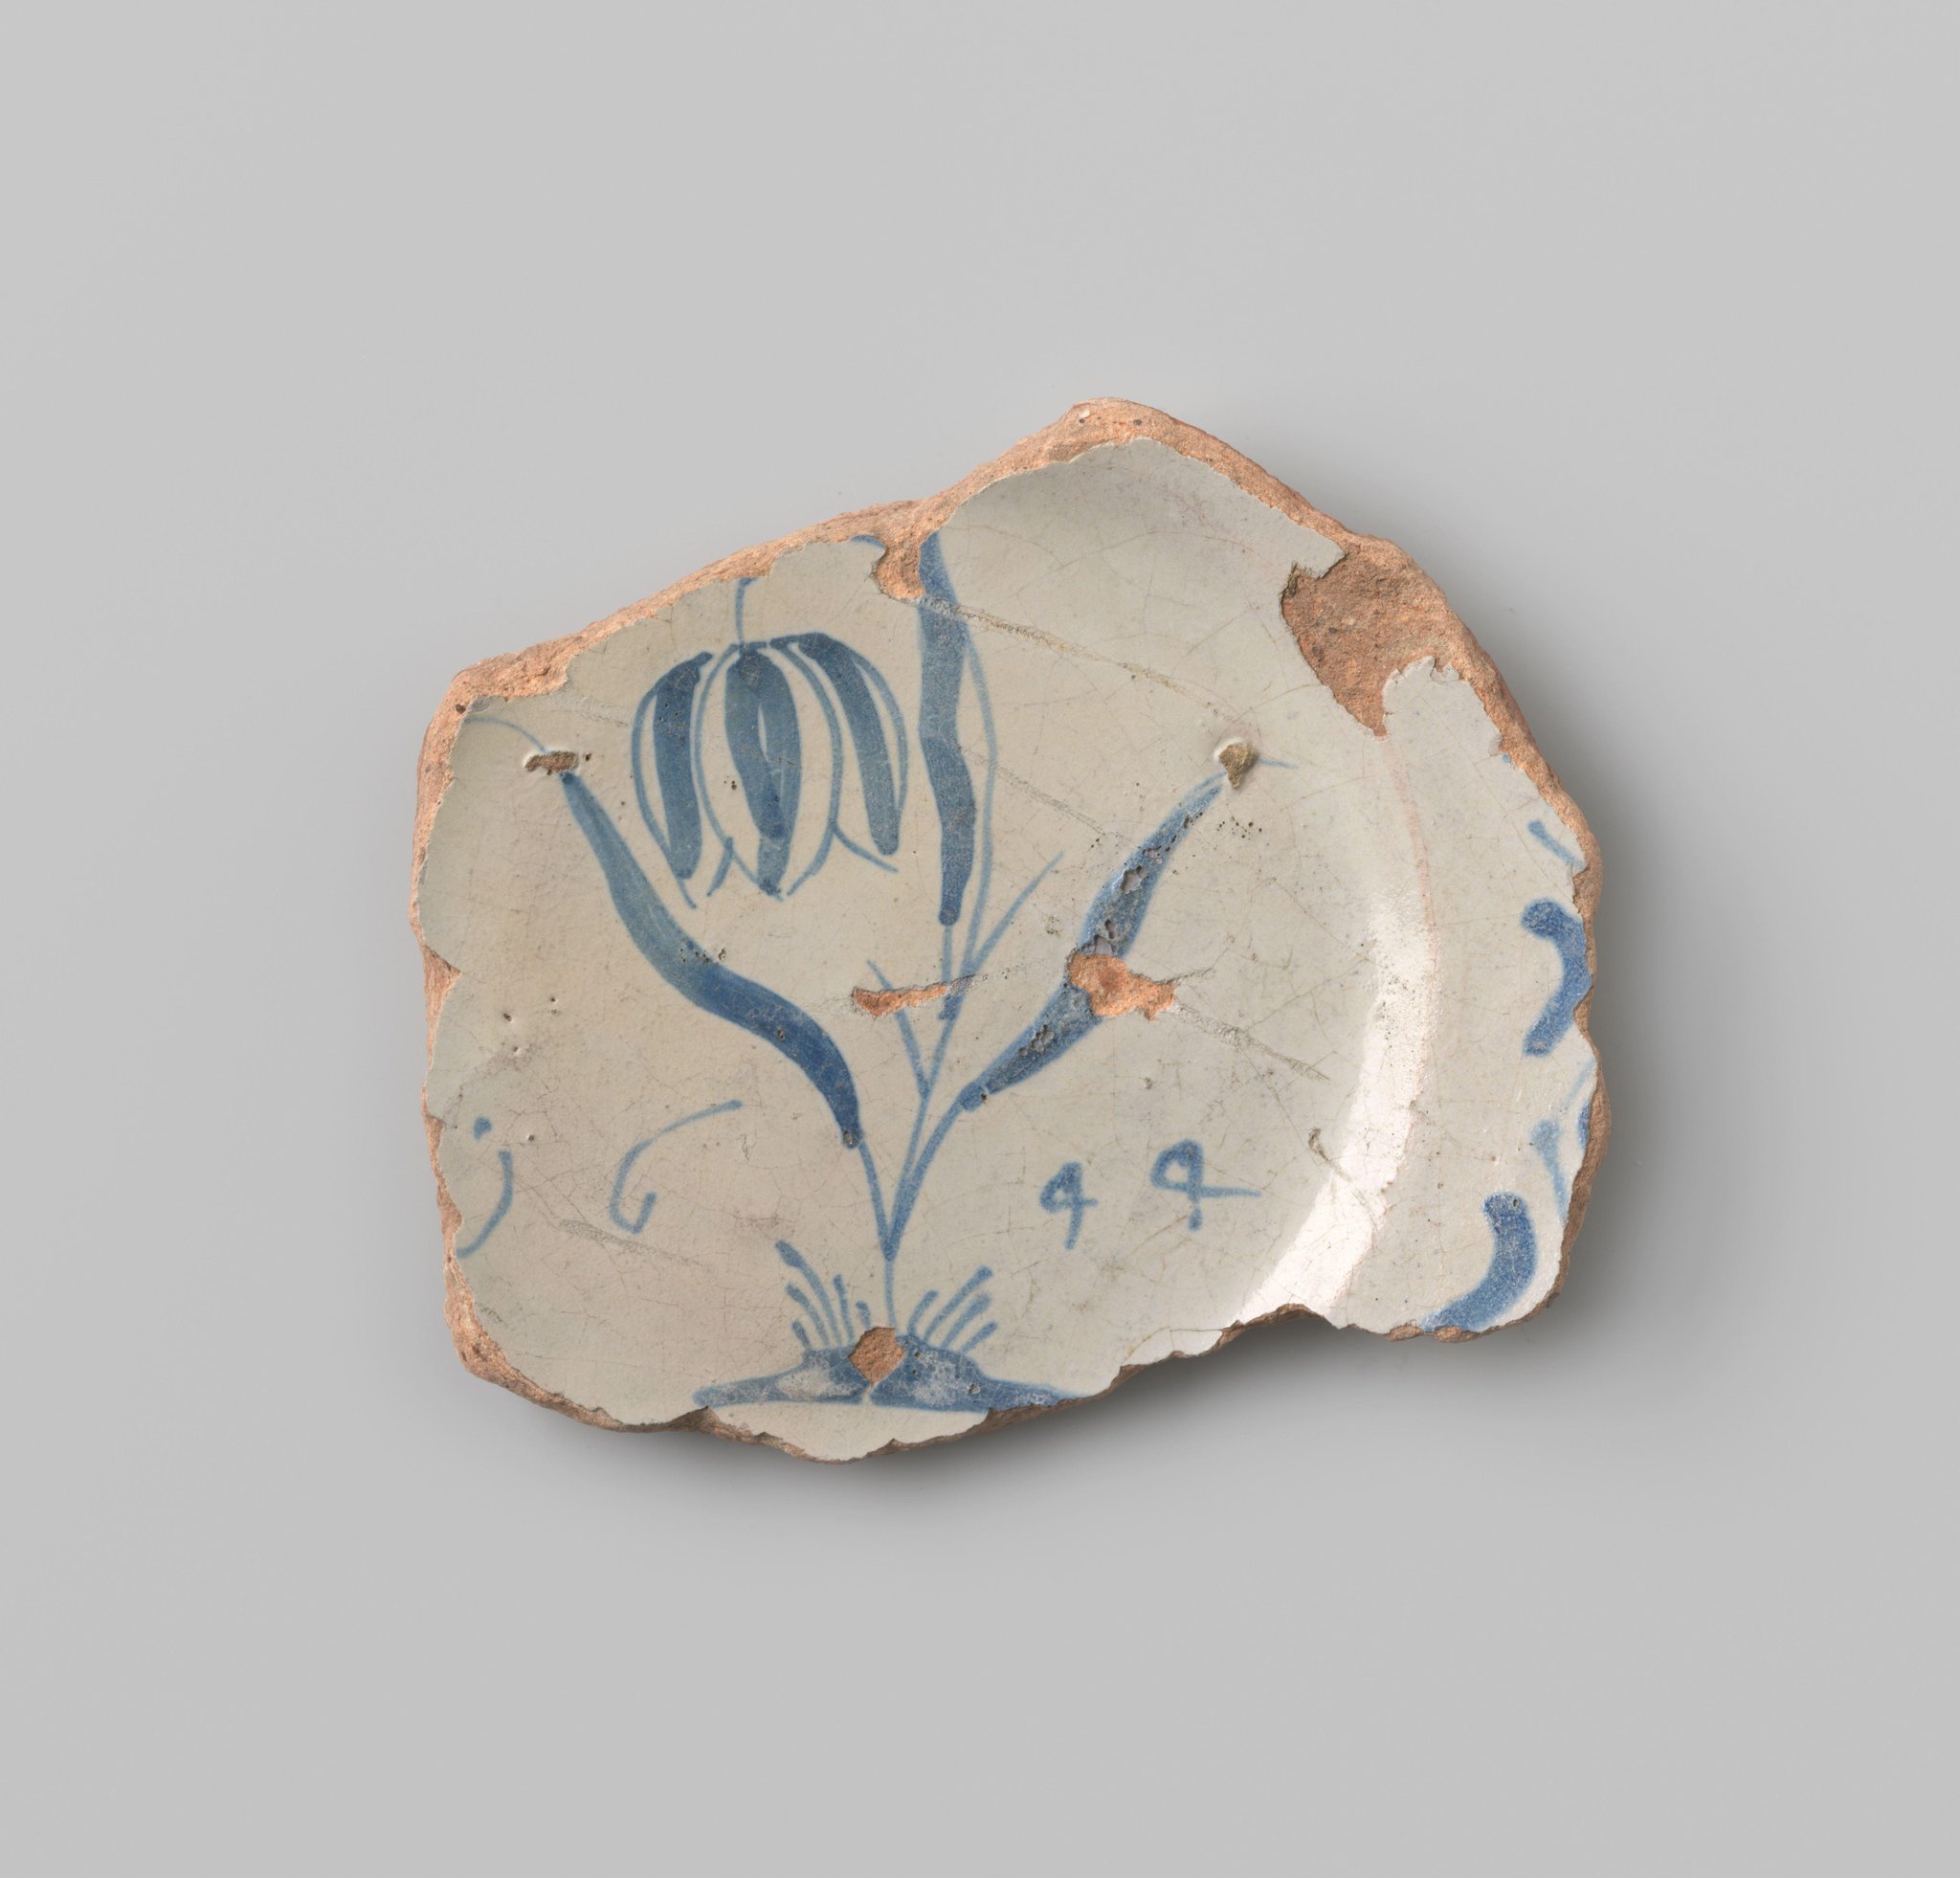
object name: sherd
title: Schotelscherf van roodbakkend aardewerk, voorzien van een schildering van een tulp met het jaartal 1644 in blauw op een witte ondergrond aan de voorzijde, en kleurloos glazuur aan de achterzijde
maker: Anonymous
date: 1500-1699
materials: earthenware, glaze